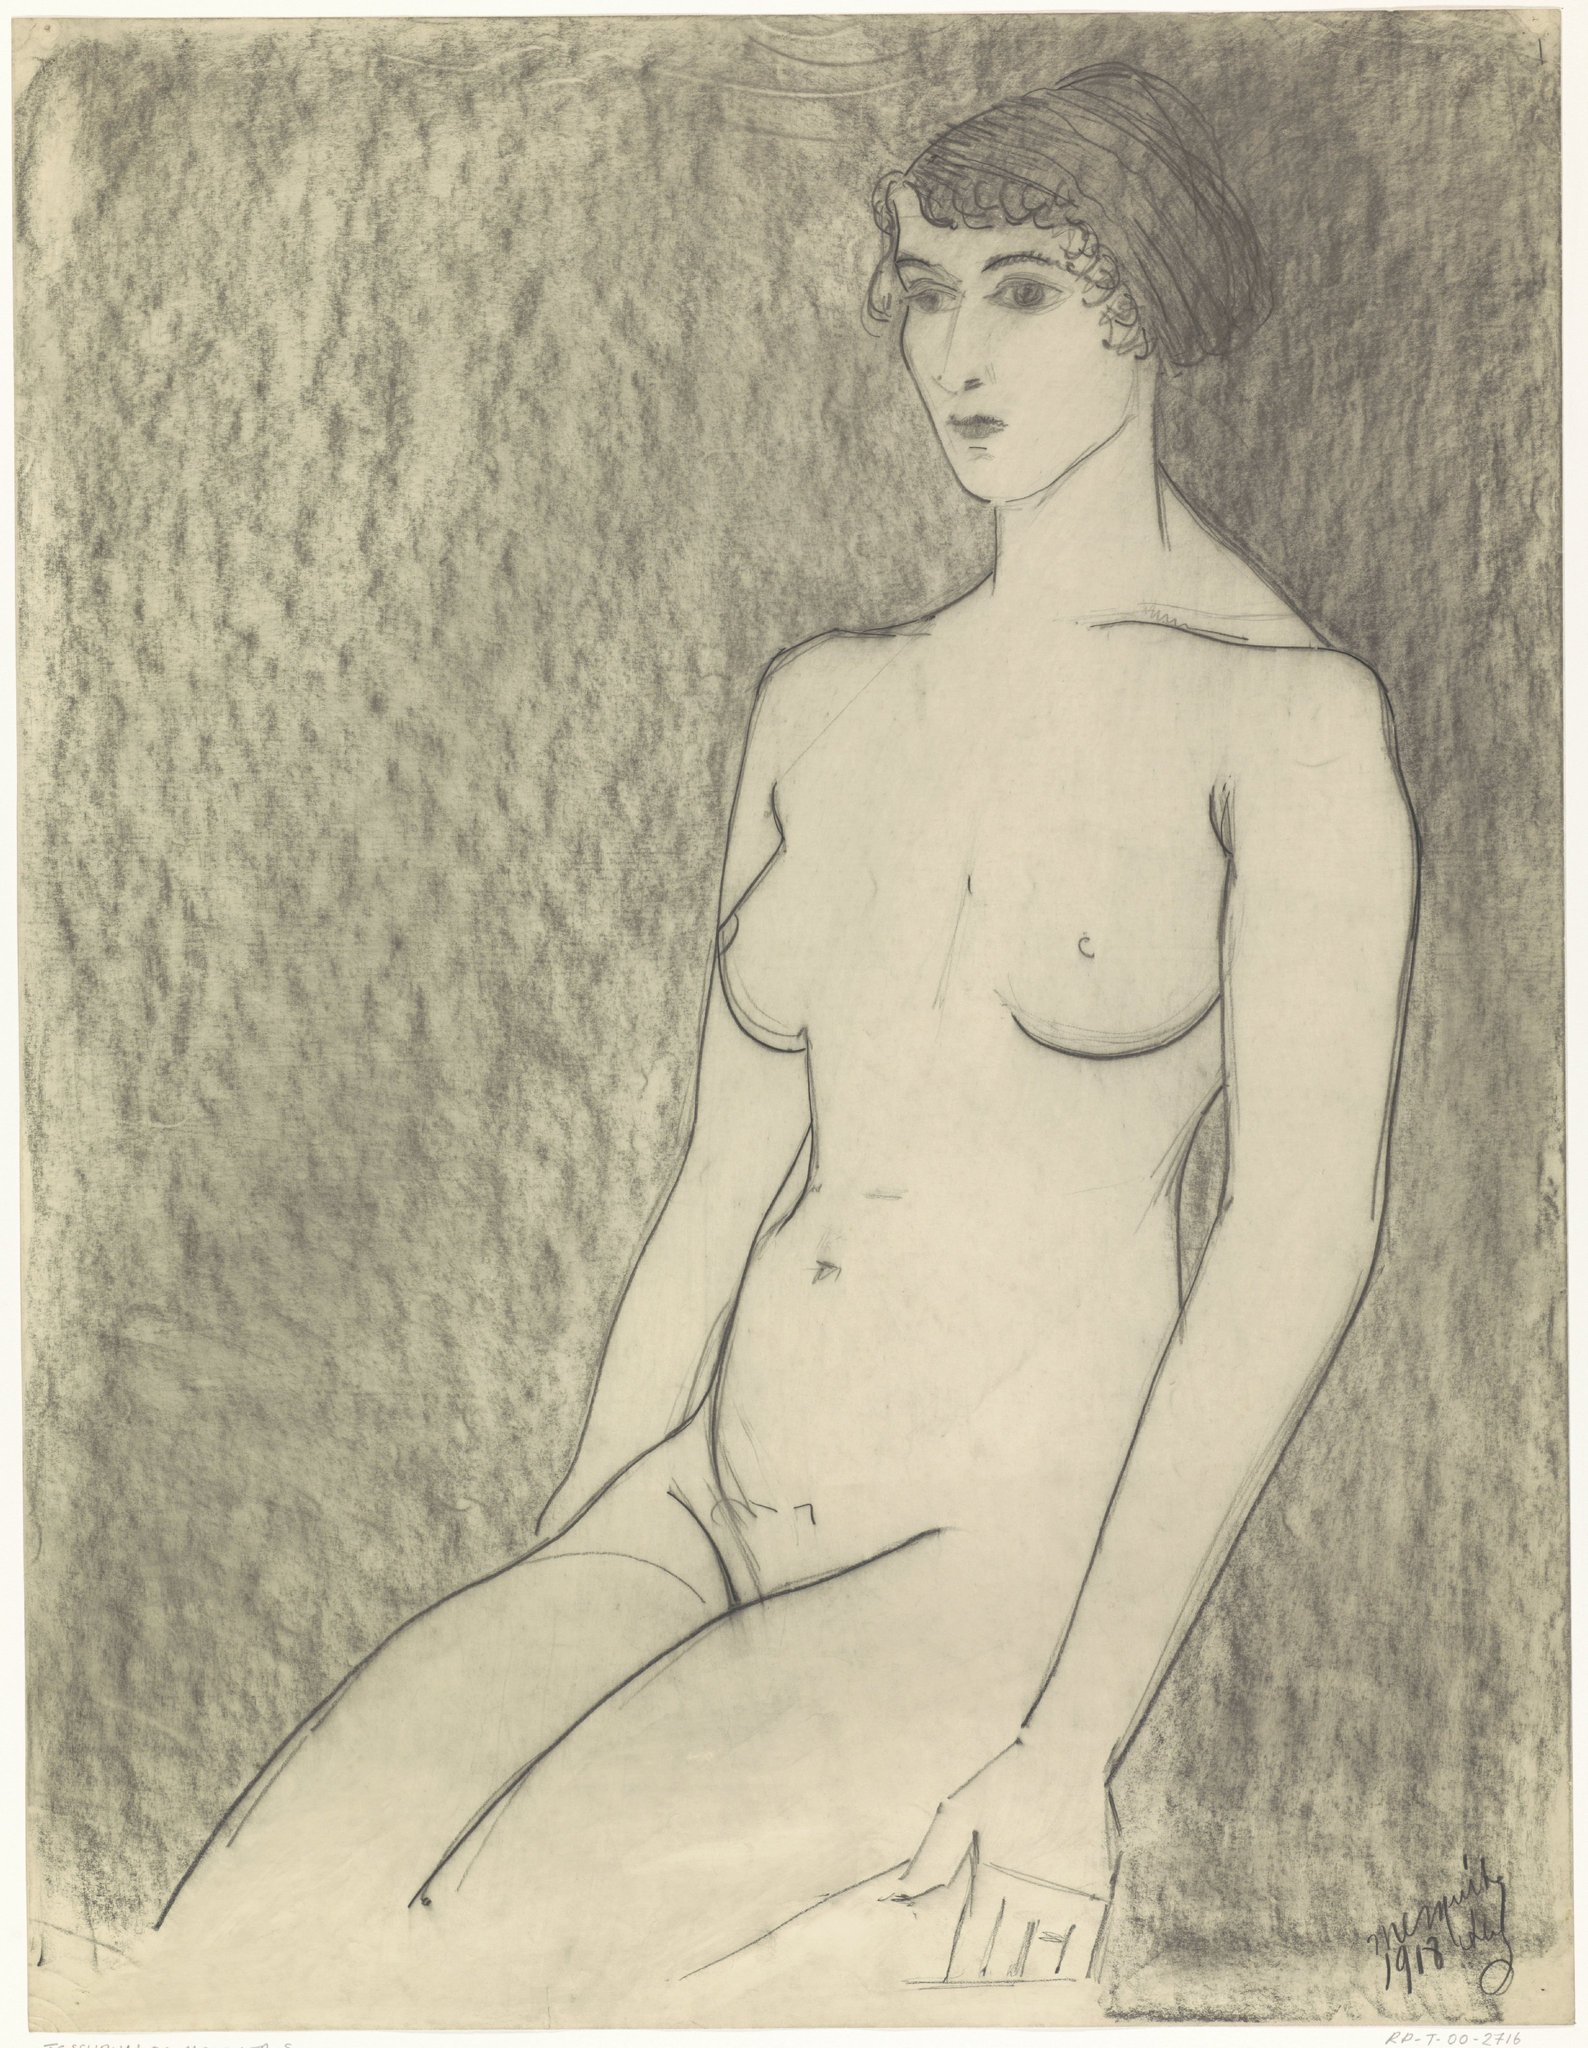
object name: drawing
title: Seated Female Nude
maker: samuel jessurun de mesquita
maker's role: draughtsman, print maker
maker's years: 1868-1944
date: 1918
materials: chalk, paper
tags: sitting figure - aa - female human figure (+ nude human being)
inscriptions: date: ‘1918 Aug’